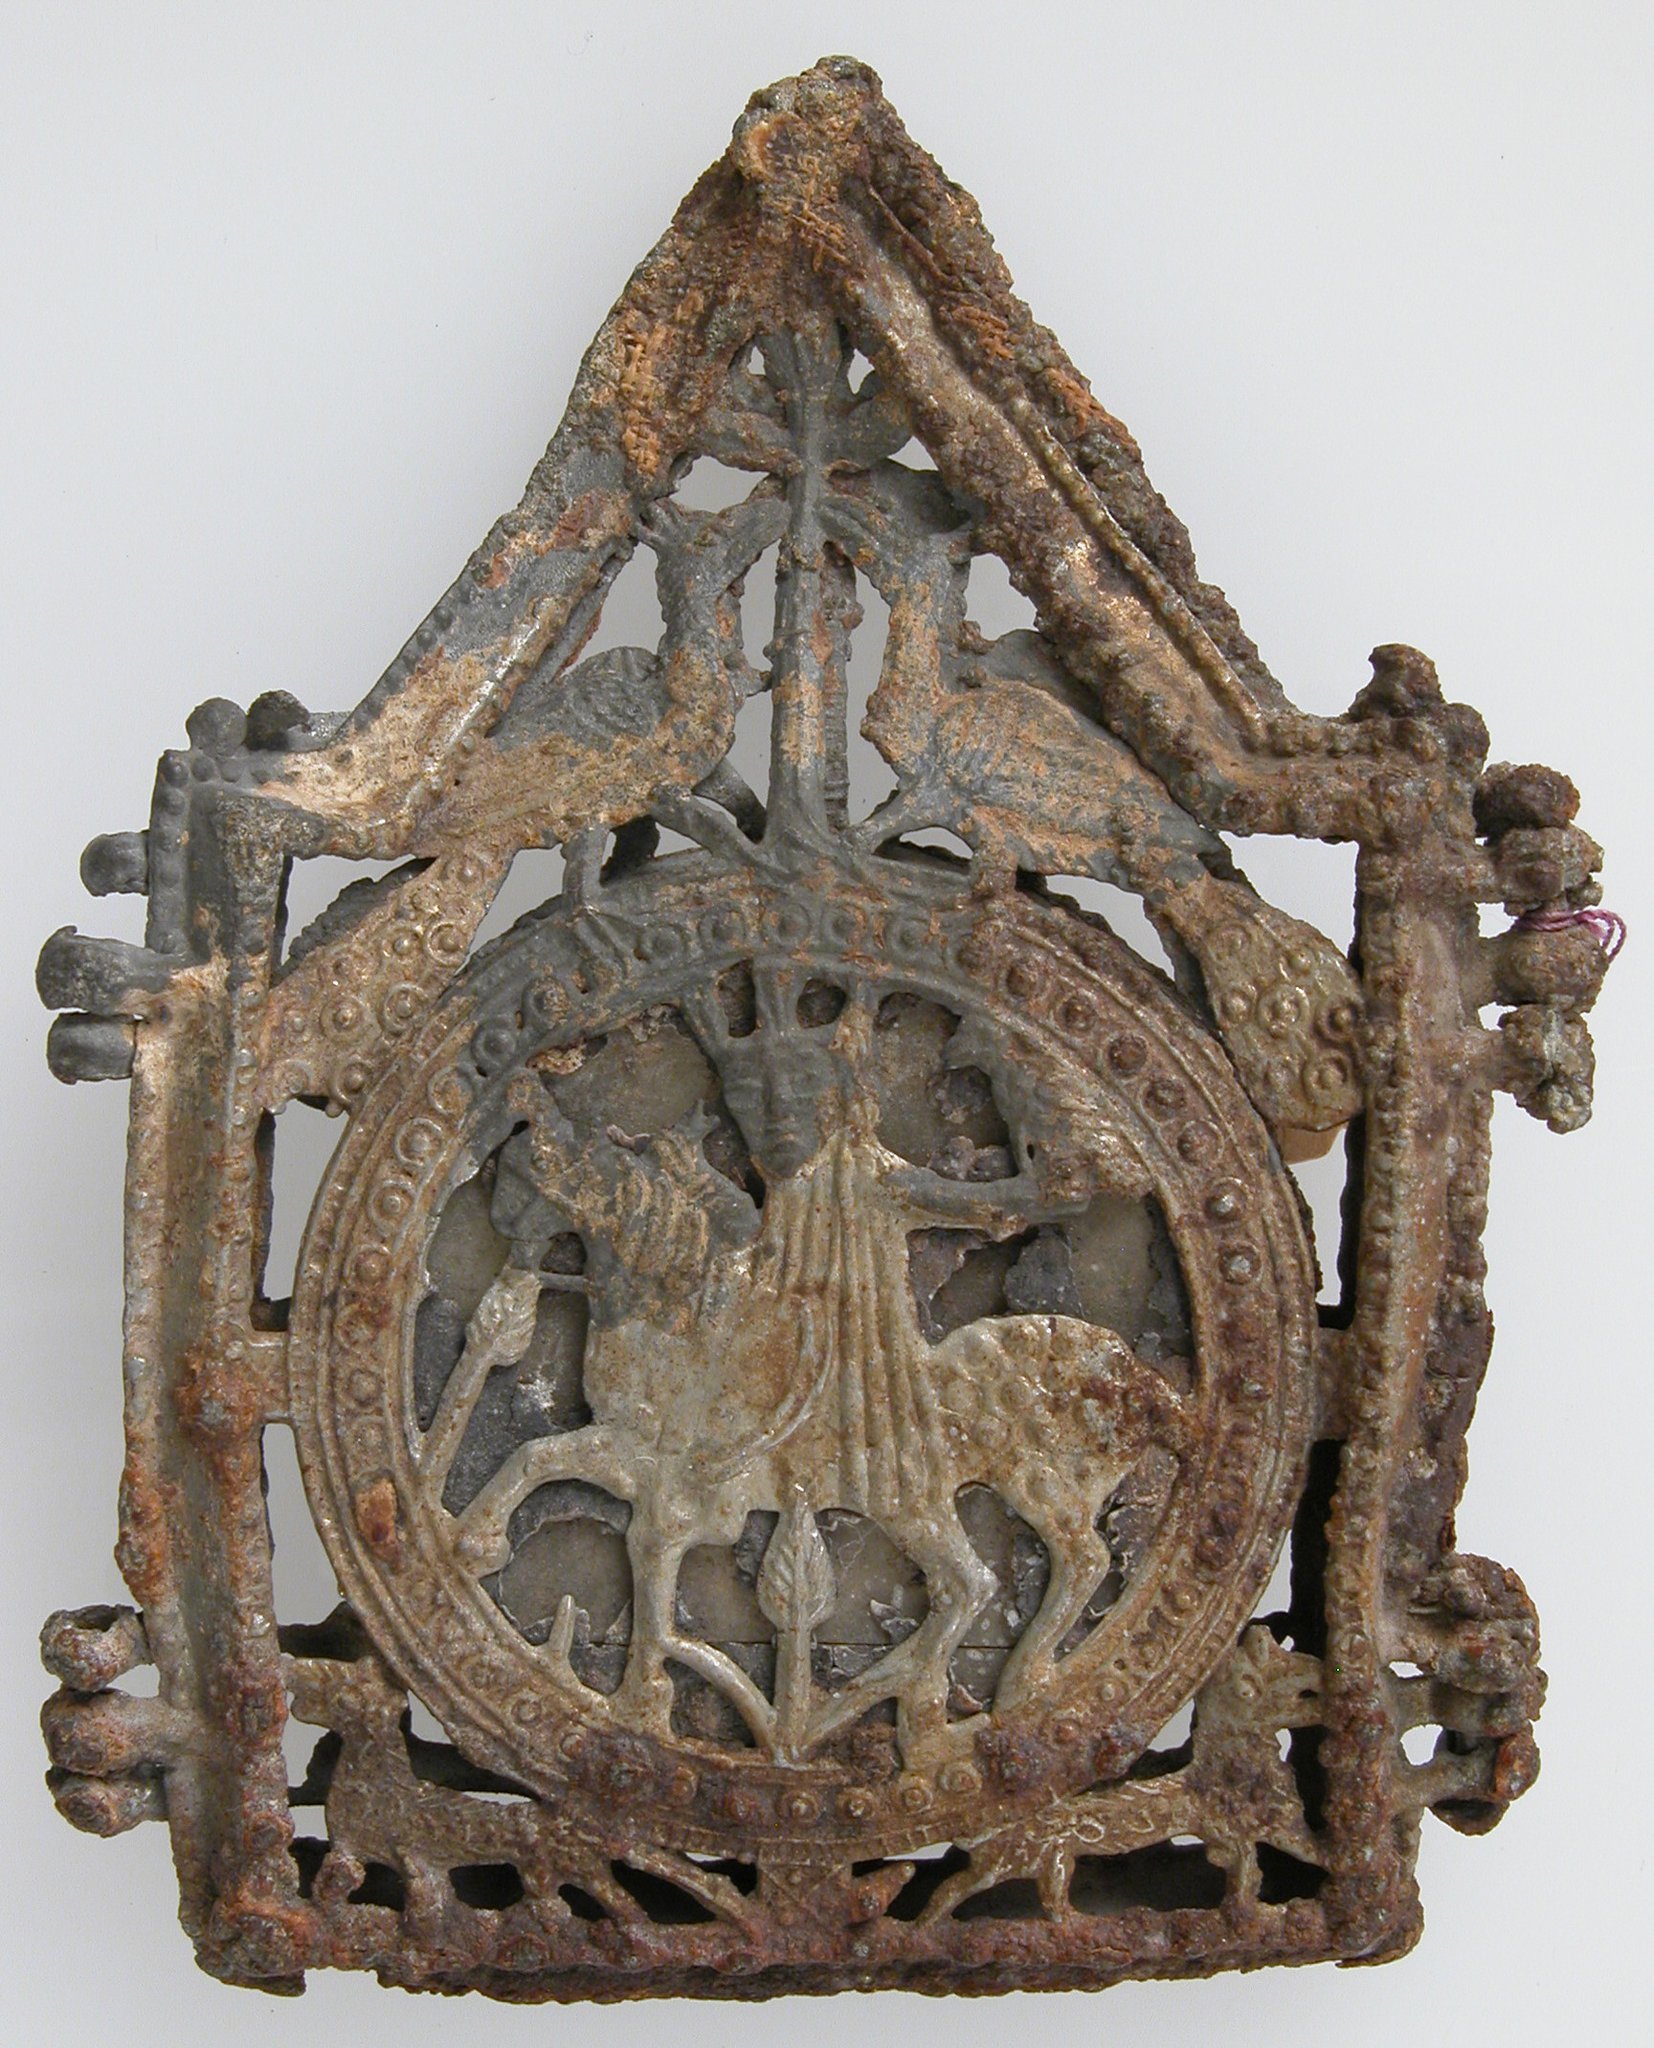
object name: pilgrim's badge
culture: european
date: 1301-1400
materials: lead, wax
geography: italy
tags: men,peacocks,horses